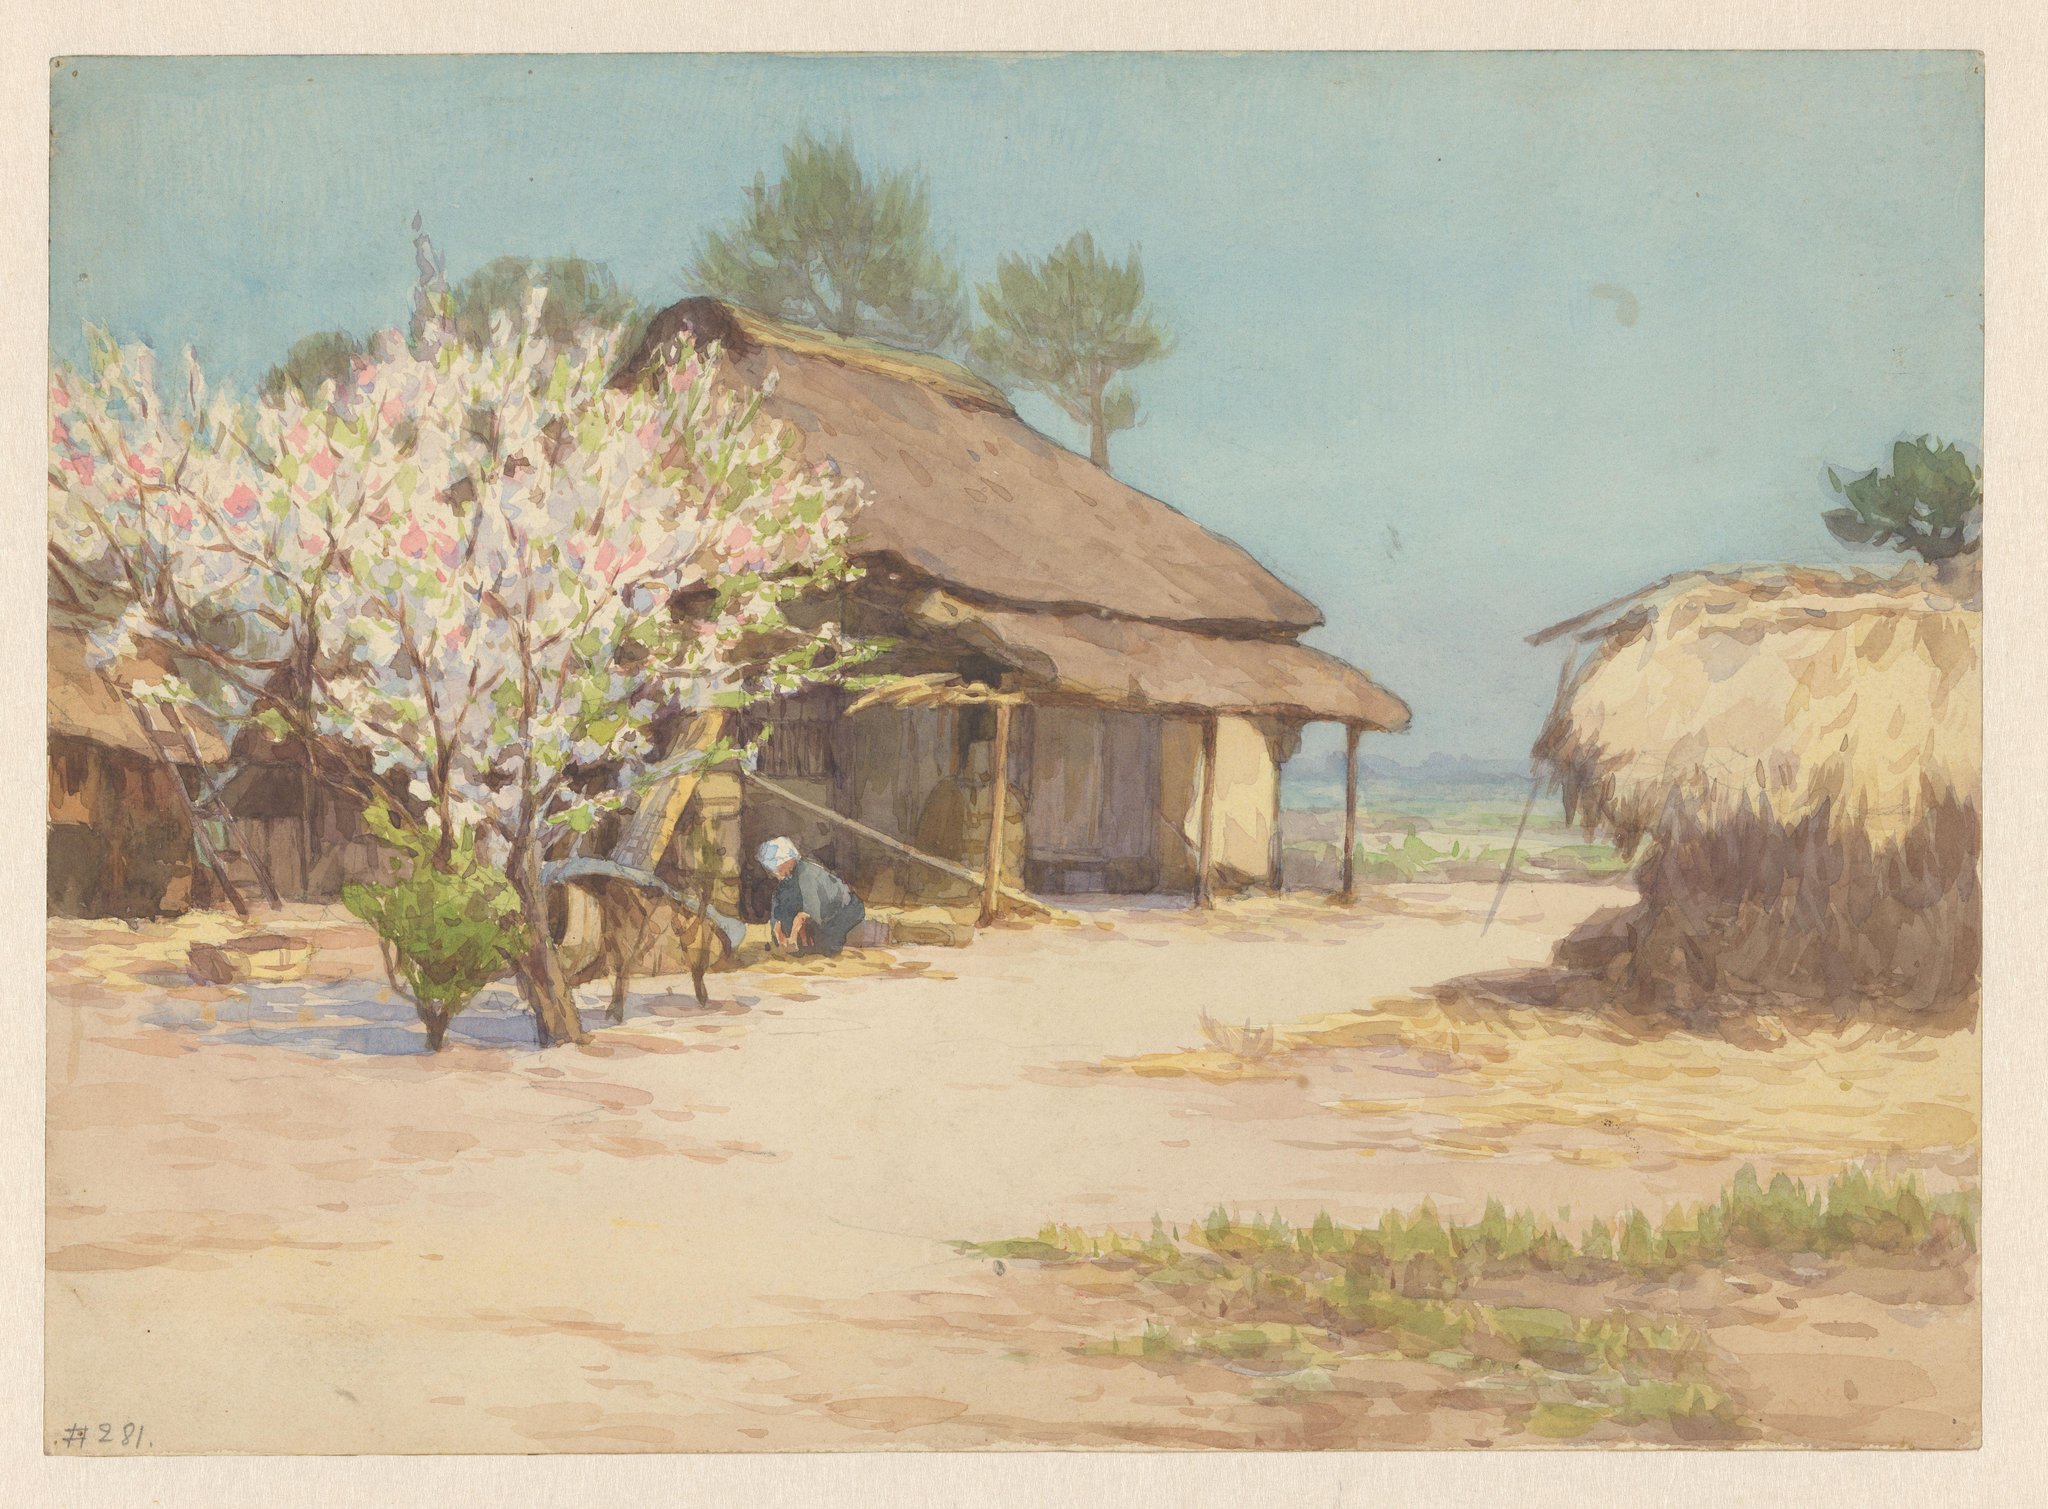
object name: watercolor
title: Farmhouse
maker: fujio yoshida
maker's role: painter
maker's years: 1887-1987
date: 1906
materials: paint, paper, watercolor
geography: japan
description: At age eleven, Fujio Yoshida was the only woman to receive lessons at Fudosha, a renowned private school of painting in Tokyo. She described her experience in her diary: ‘It must have been a strange sight, a woman among all those men. I was embarrassed when people from the village came to watch us during our outdoor lessons.’